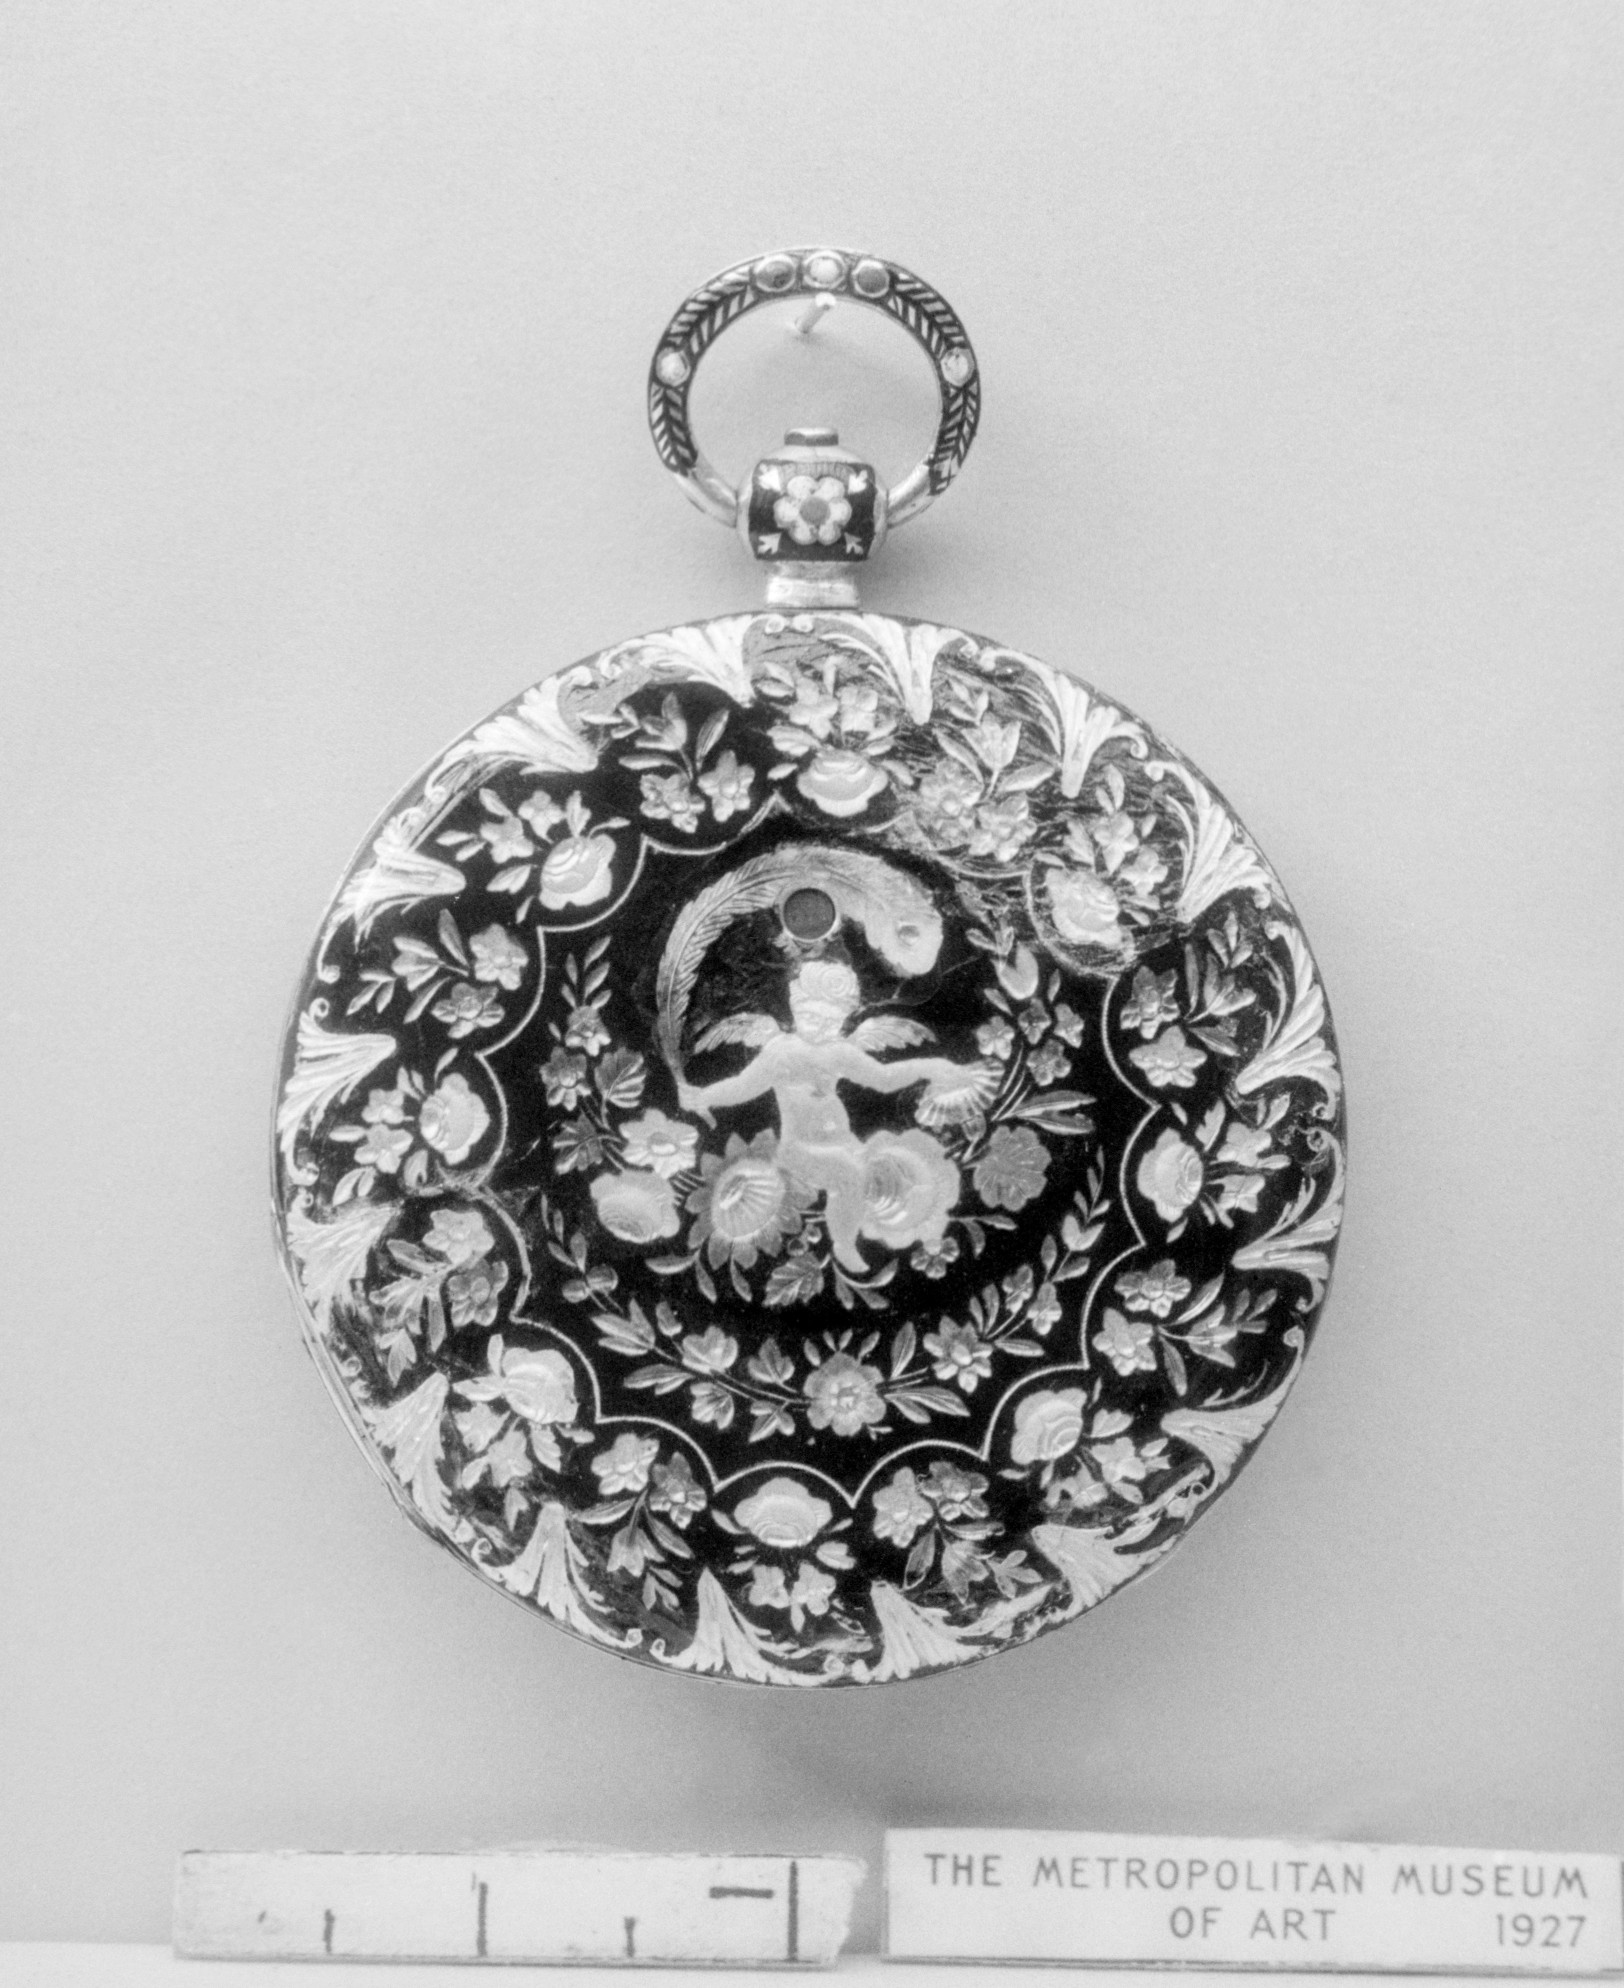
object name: watch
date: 1845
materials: enamel, gold, silver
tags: putti,flowers